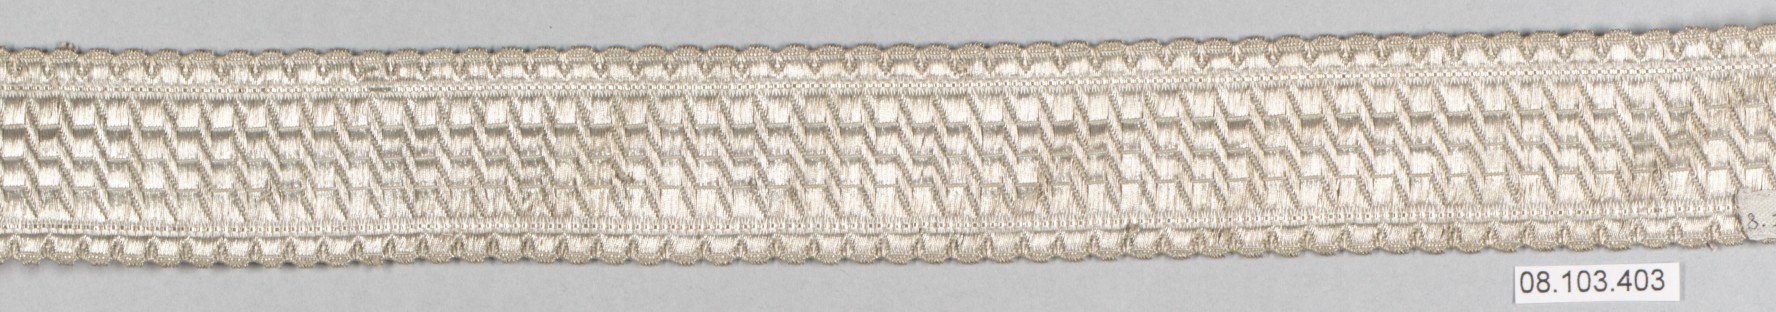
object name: galloon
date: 1701-1900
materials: metal thread